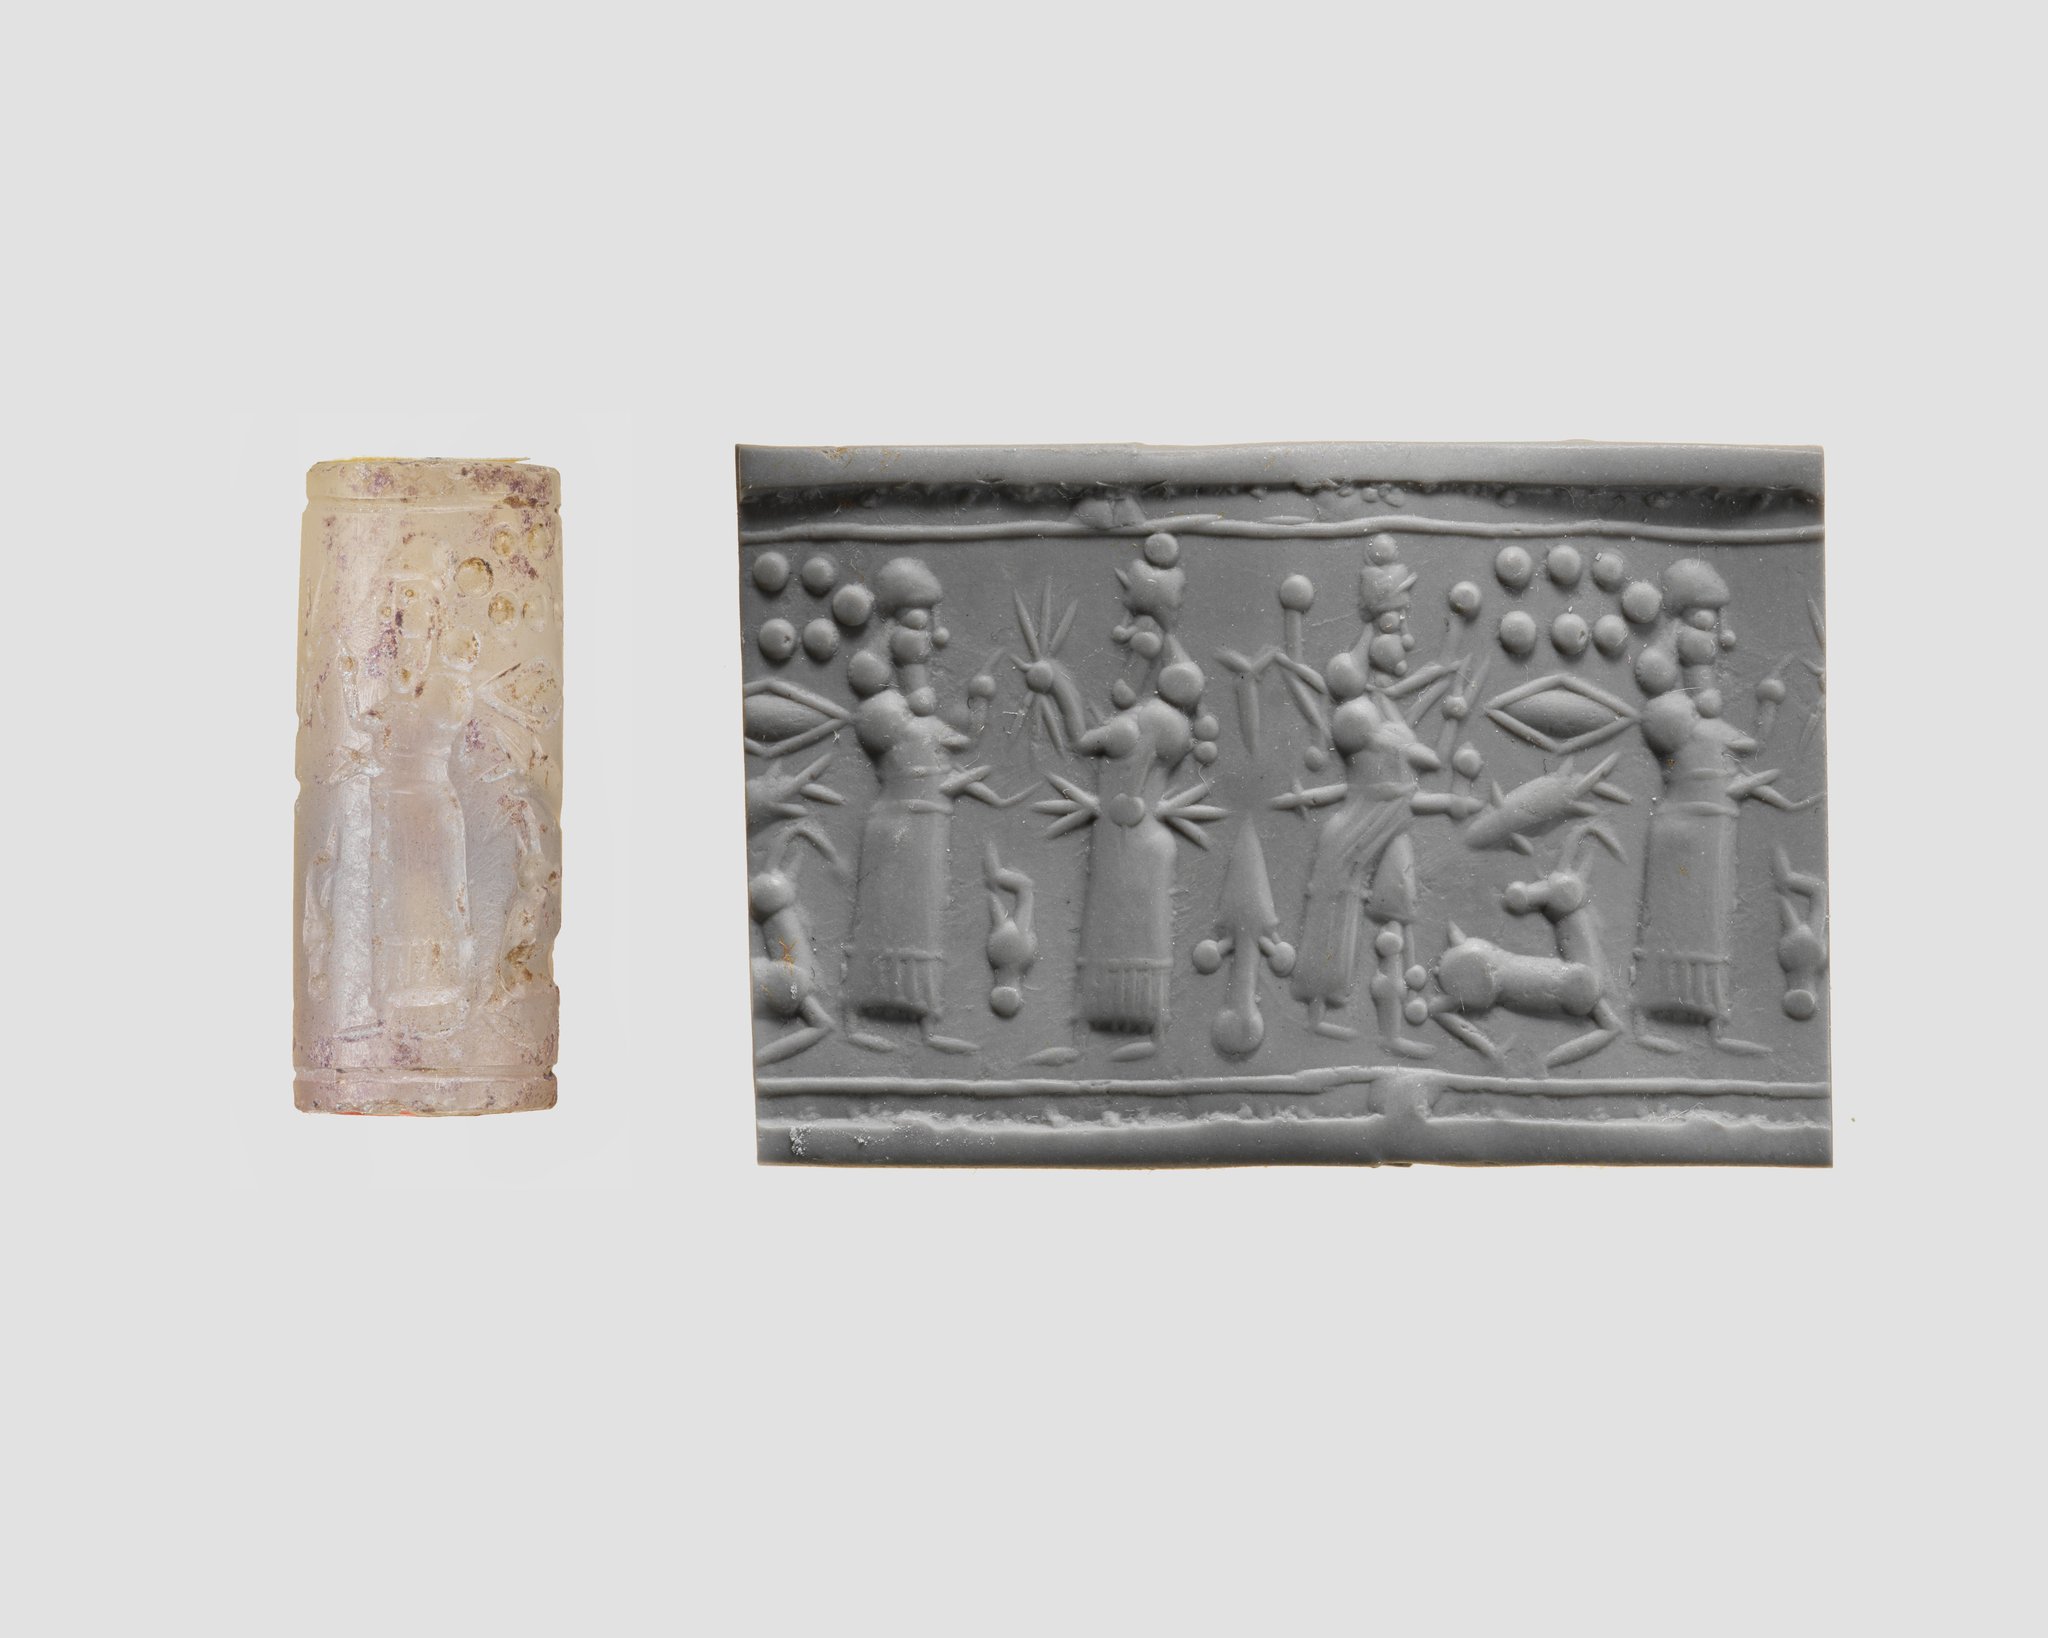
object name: cylinder seal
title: Cylinder seal with cultic scene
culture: assyrian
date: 800-601 BCE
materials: stone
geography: mesopotamia